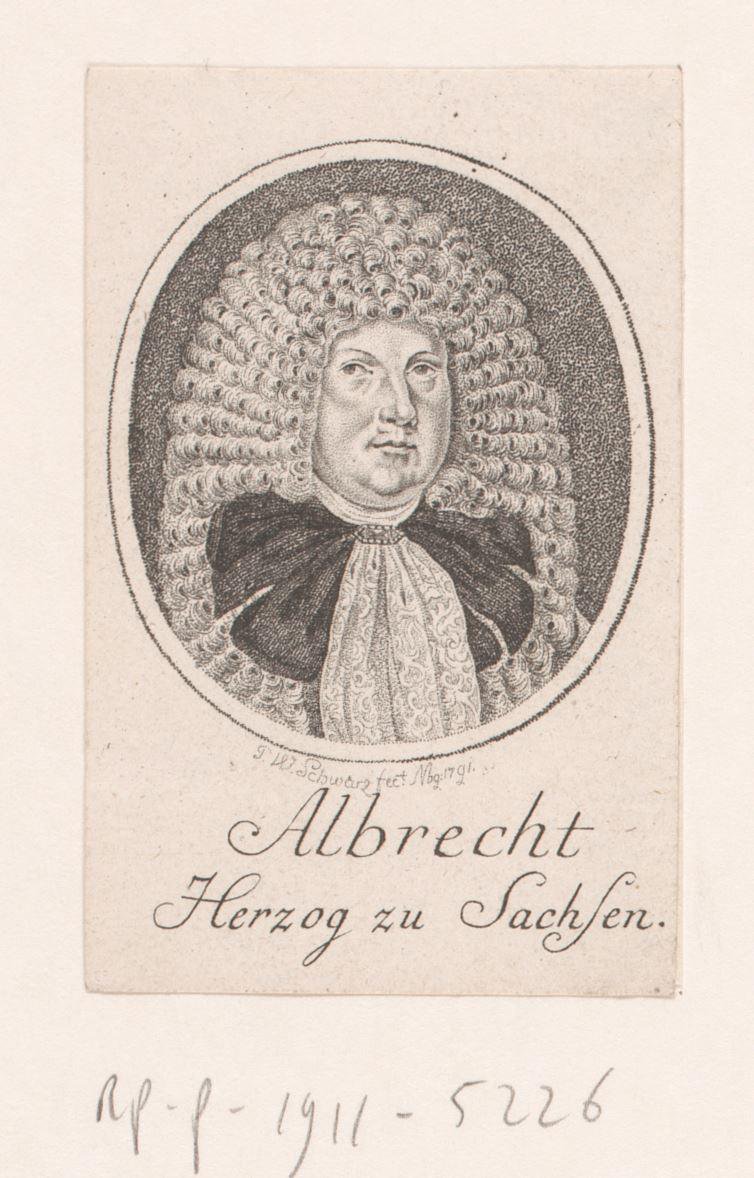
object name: print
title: Portret van Albrecht von Sachsen-Gotha-Altenburg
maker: paul wolfgang schwarz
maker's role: print maker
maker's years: -1815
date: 1791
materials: paper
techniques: engraving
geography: nuremberg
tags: historical persons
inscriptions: collector's mark: Lugt 2228